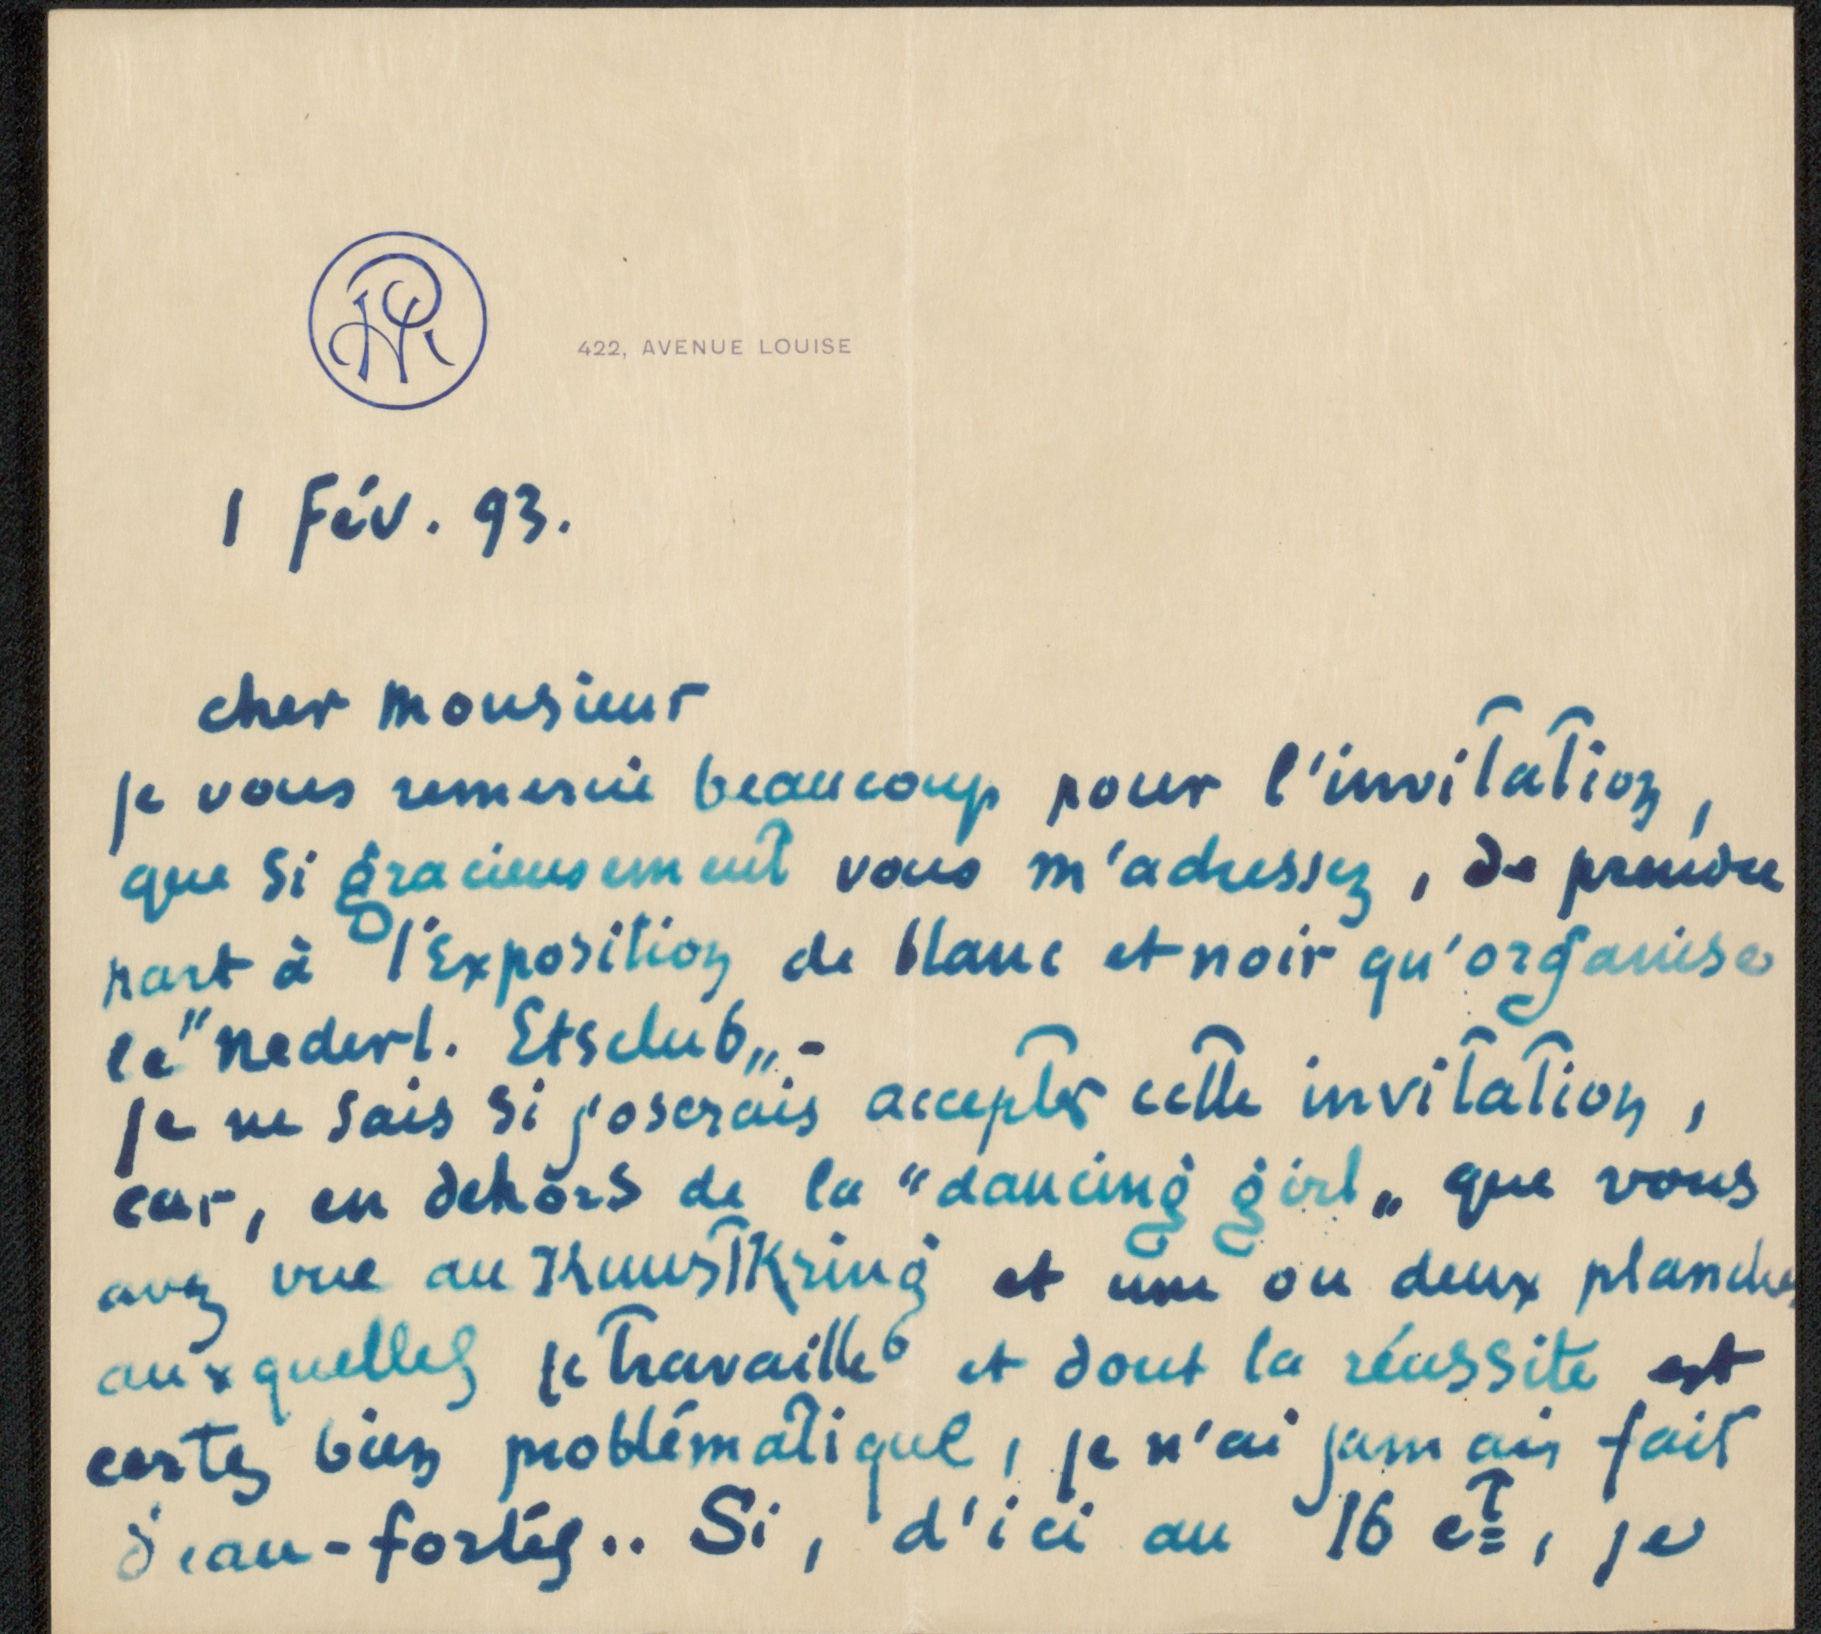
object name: letter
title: Brief aan Philip Zilcken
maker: theo van rysselberghe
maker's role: draughtsman, print maker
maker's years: 1862-1926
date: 1893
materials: ink, paper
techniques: pen, printing, writing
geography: brussels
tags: the hague, draughtsman, philip zilcken, the graphic arts, exhibition ~ art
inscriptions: monogram: ‘VR’, collector's mark: ‘RPK’